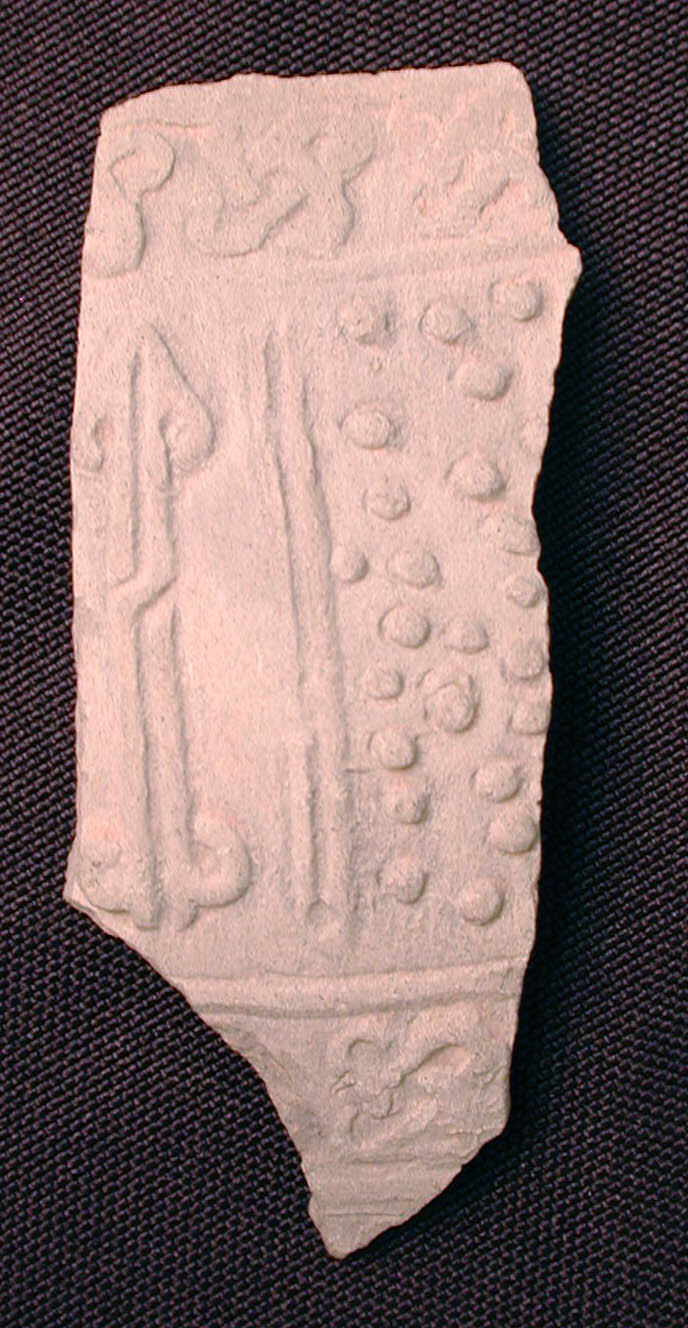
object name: fragment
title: Ceramic Fragment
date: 1001-1200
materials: earthenware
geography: iran